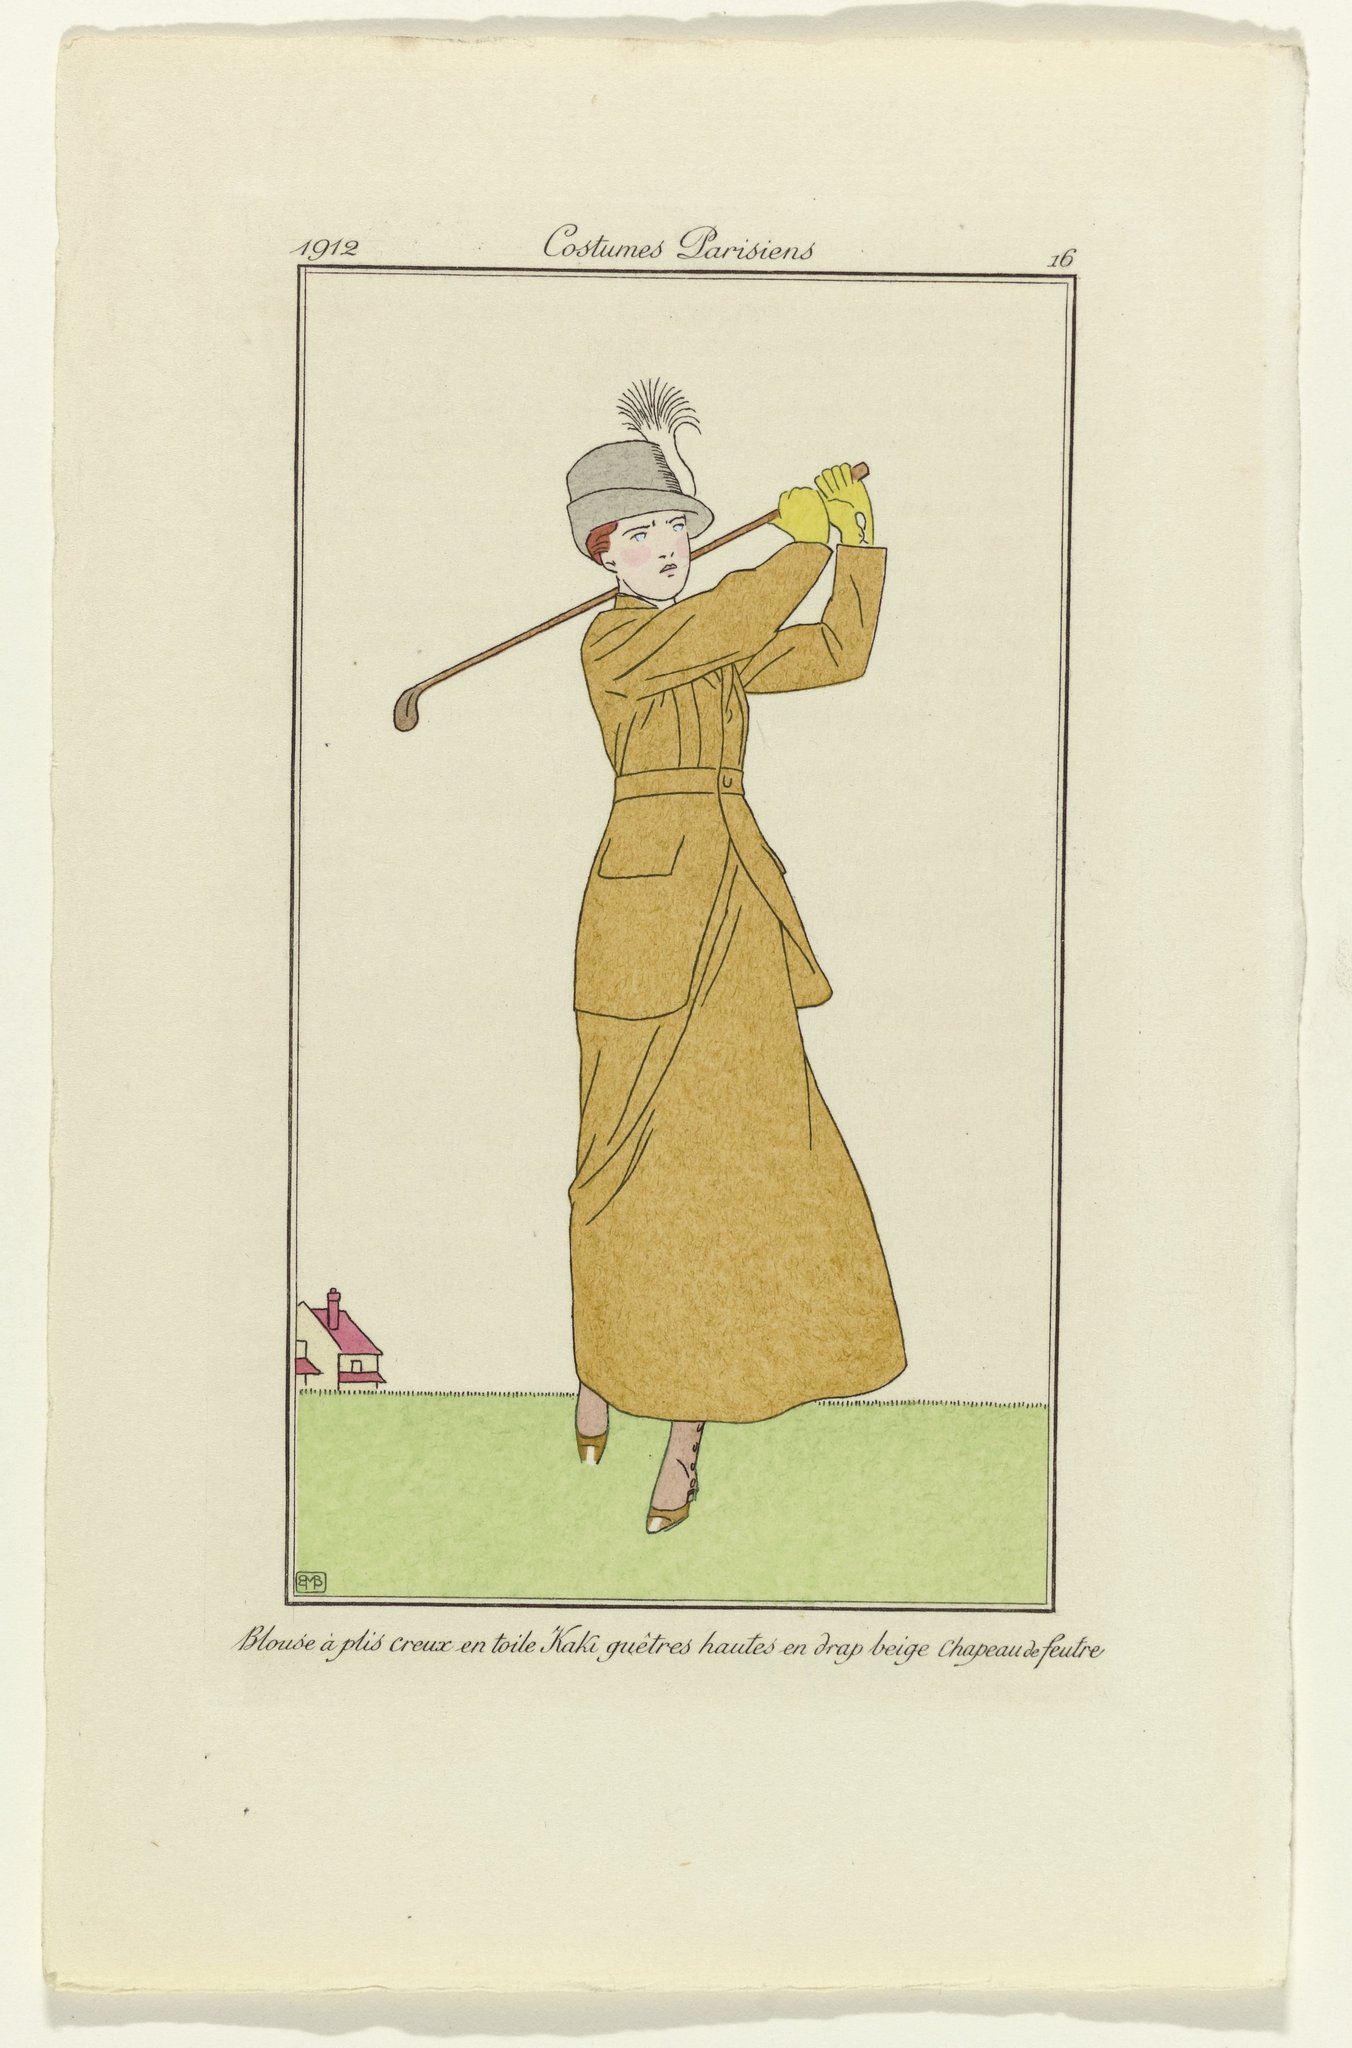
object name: fashion print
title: Journal des Dames et des Modes, 1912, Costumes Parisiens, no. 16: Blouse à plis creux en toile Kak (...)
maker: Anonymous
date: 1912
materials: paper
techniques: engraving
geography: paris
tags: fashion plates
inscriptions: caption: ‘Robe de promenade en Sarah à damiers et taffetas peint à la main, bordée de velours noir: Chapeau de paille orné d'un panache en duvet de Cygne’